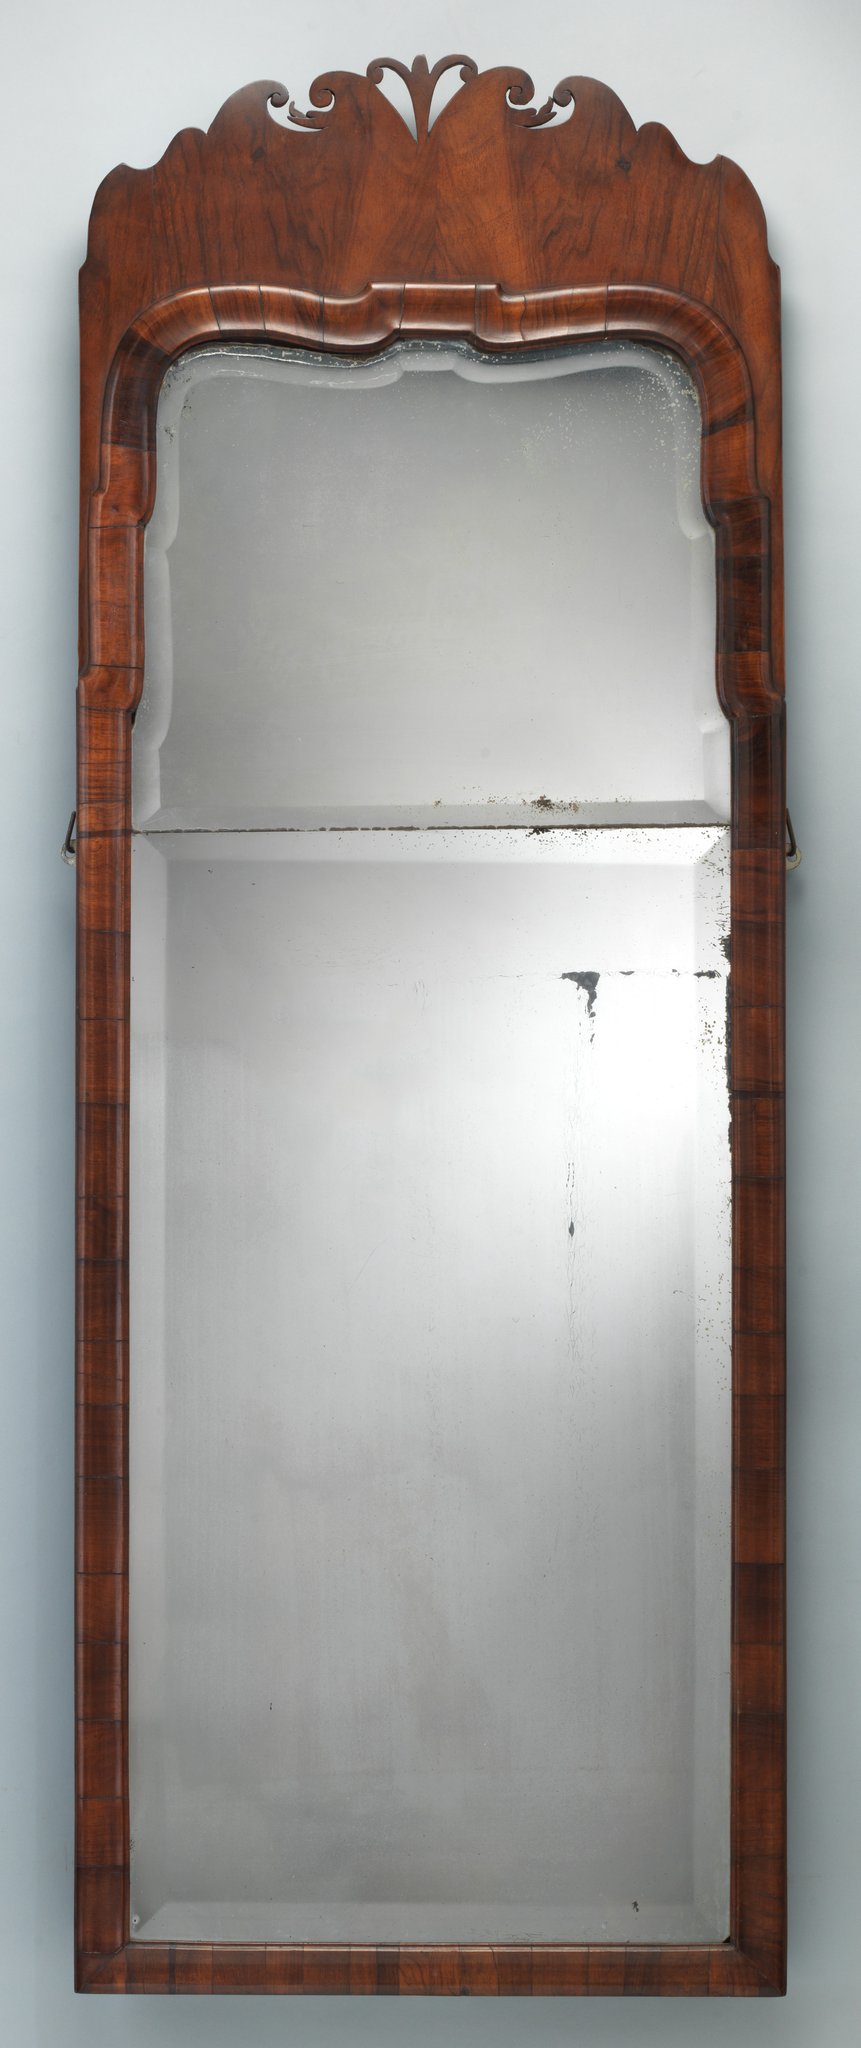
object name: looking glass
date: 1701-1733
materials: wood